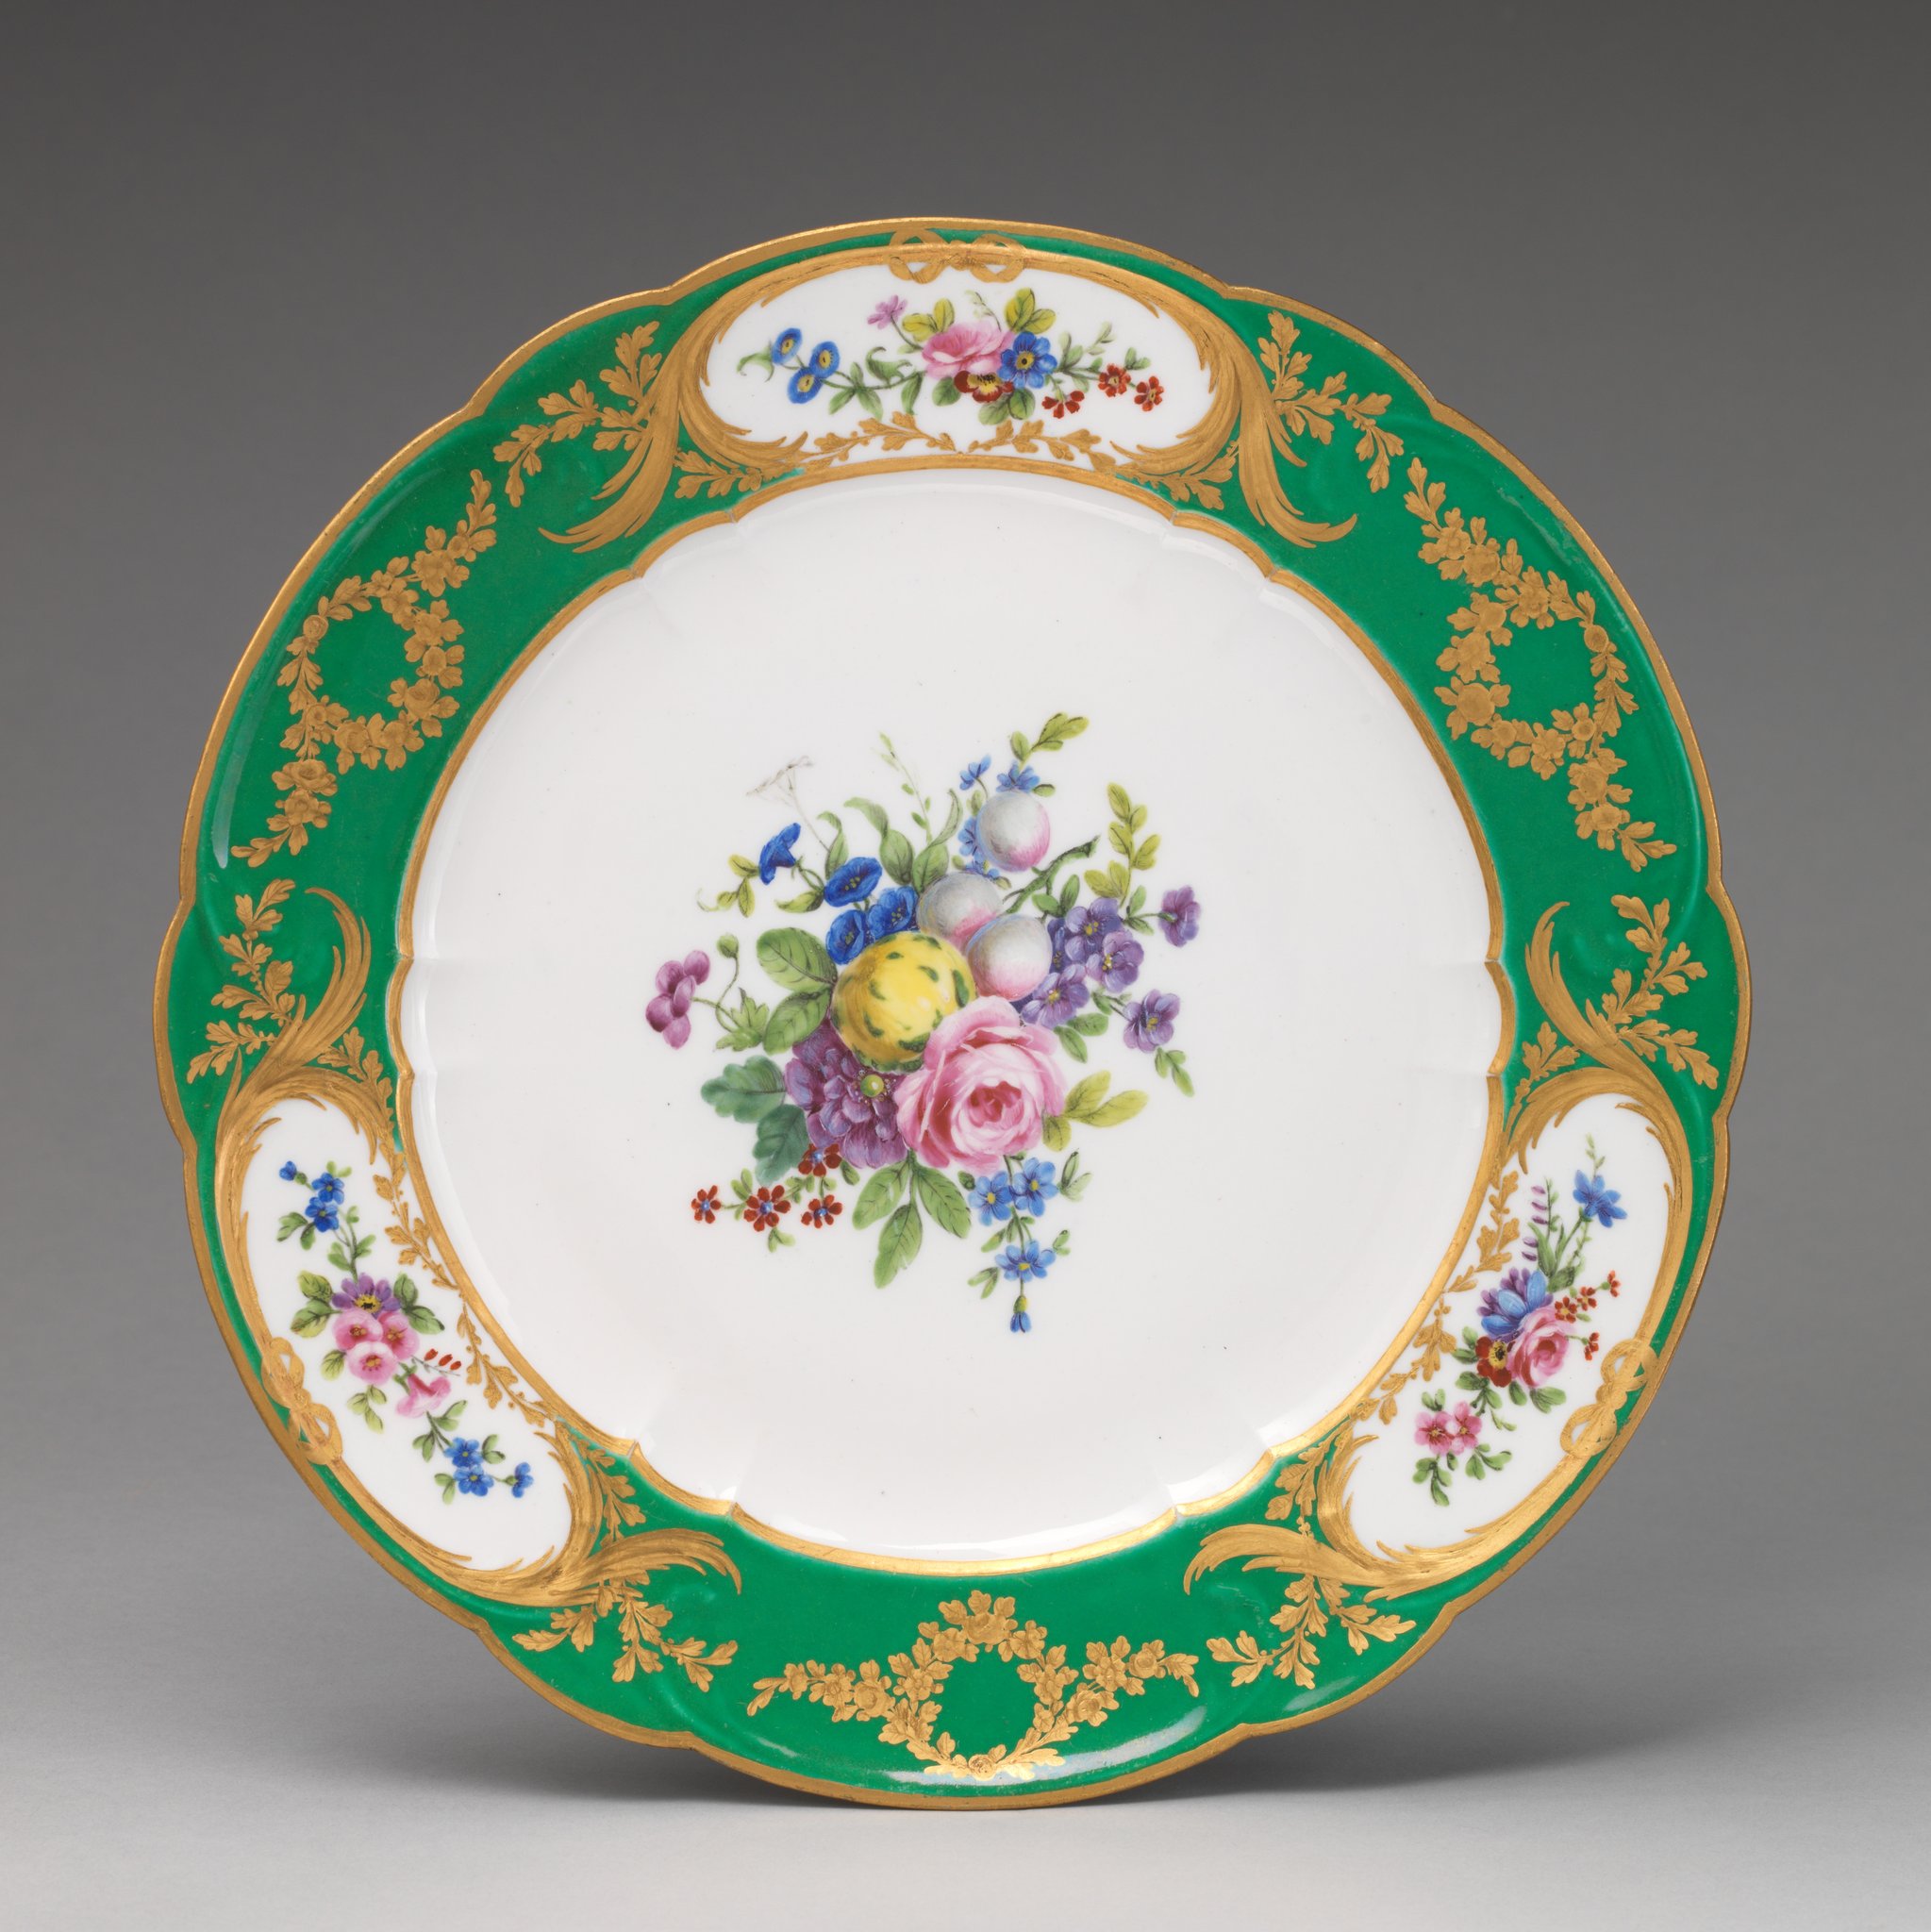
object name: plate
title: Plate (part of a service)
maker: sèvres manufactory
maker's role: manufactory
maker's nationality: french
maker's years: 1740-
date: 1784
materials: soft paste porcelain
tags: flowers